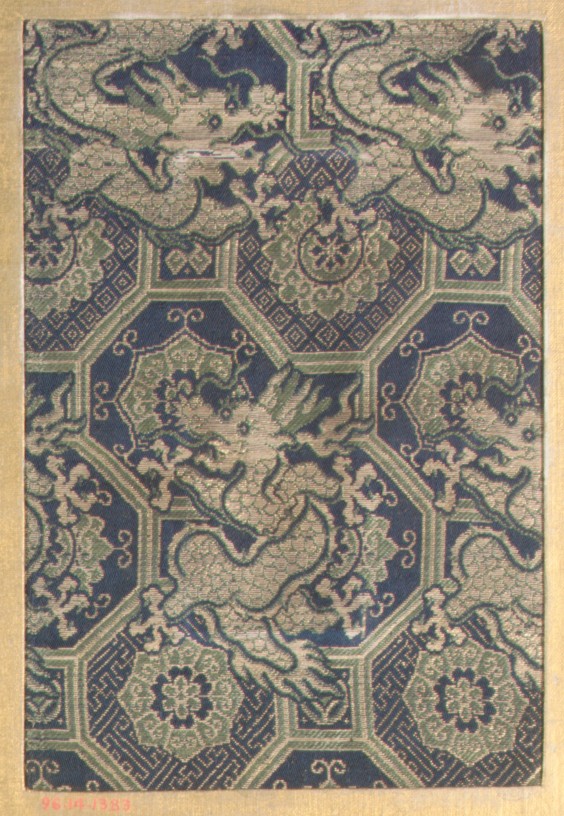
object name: piece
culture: japanese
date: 1701-1900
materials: silk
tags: dragons